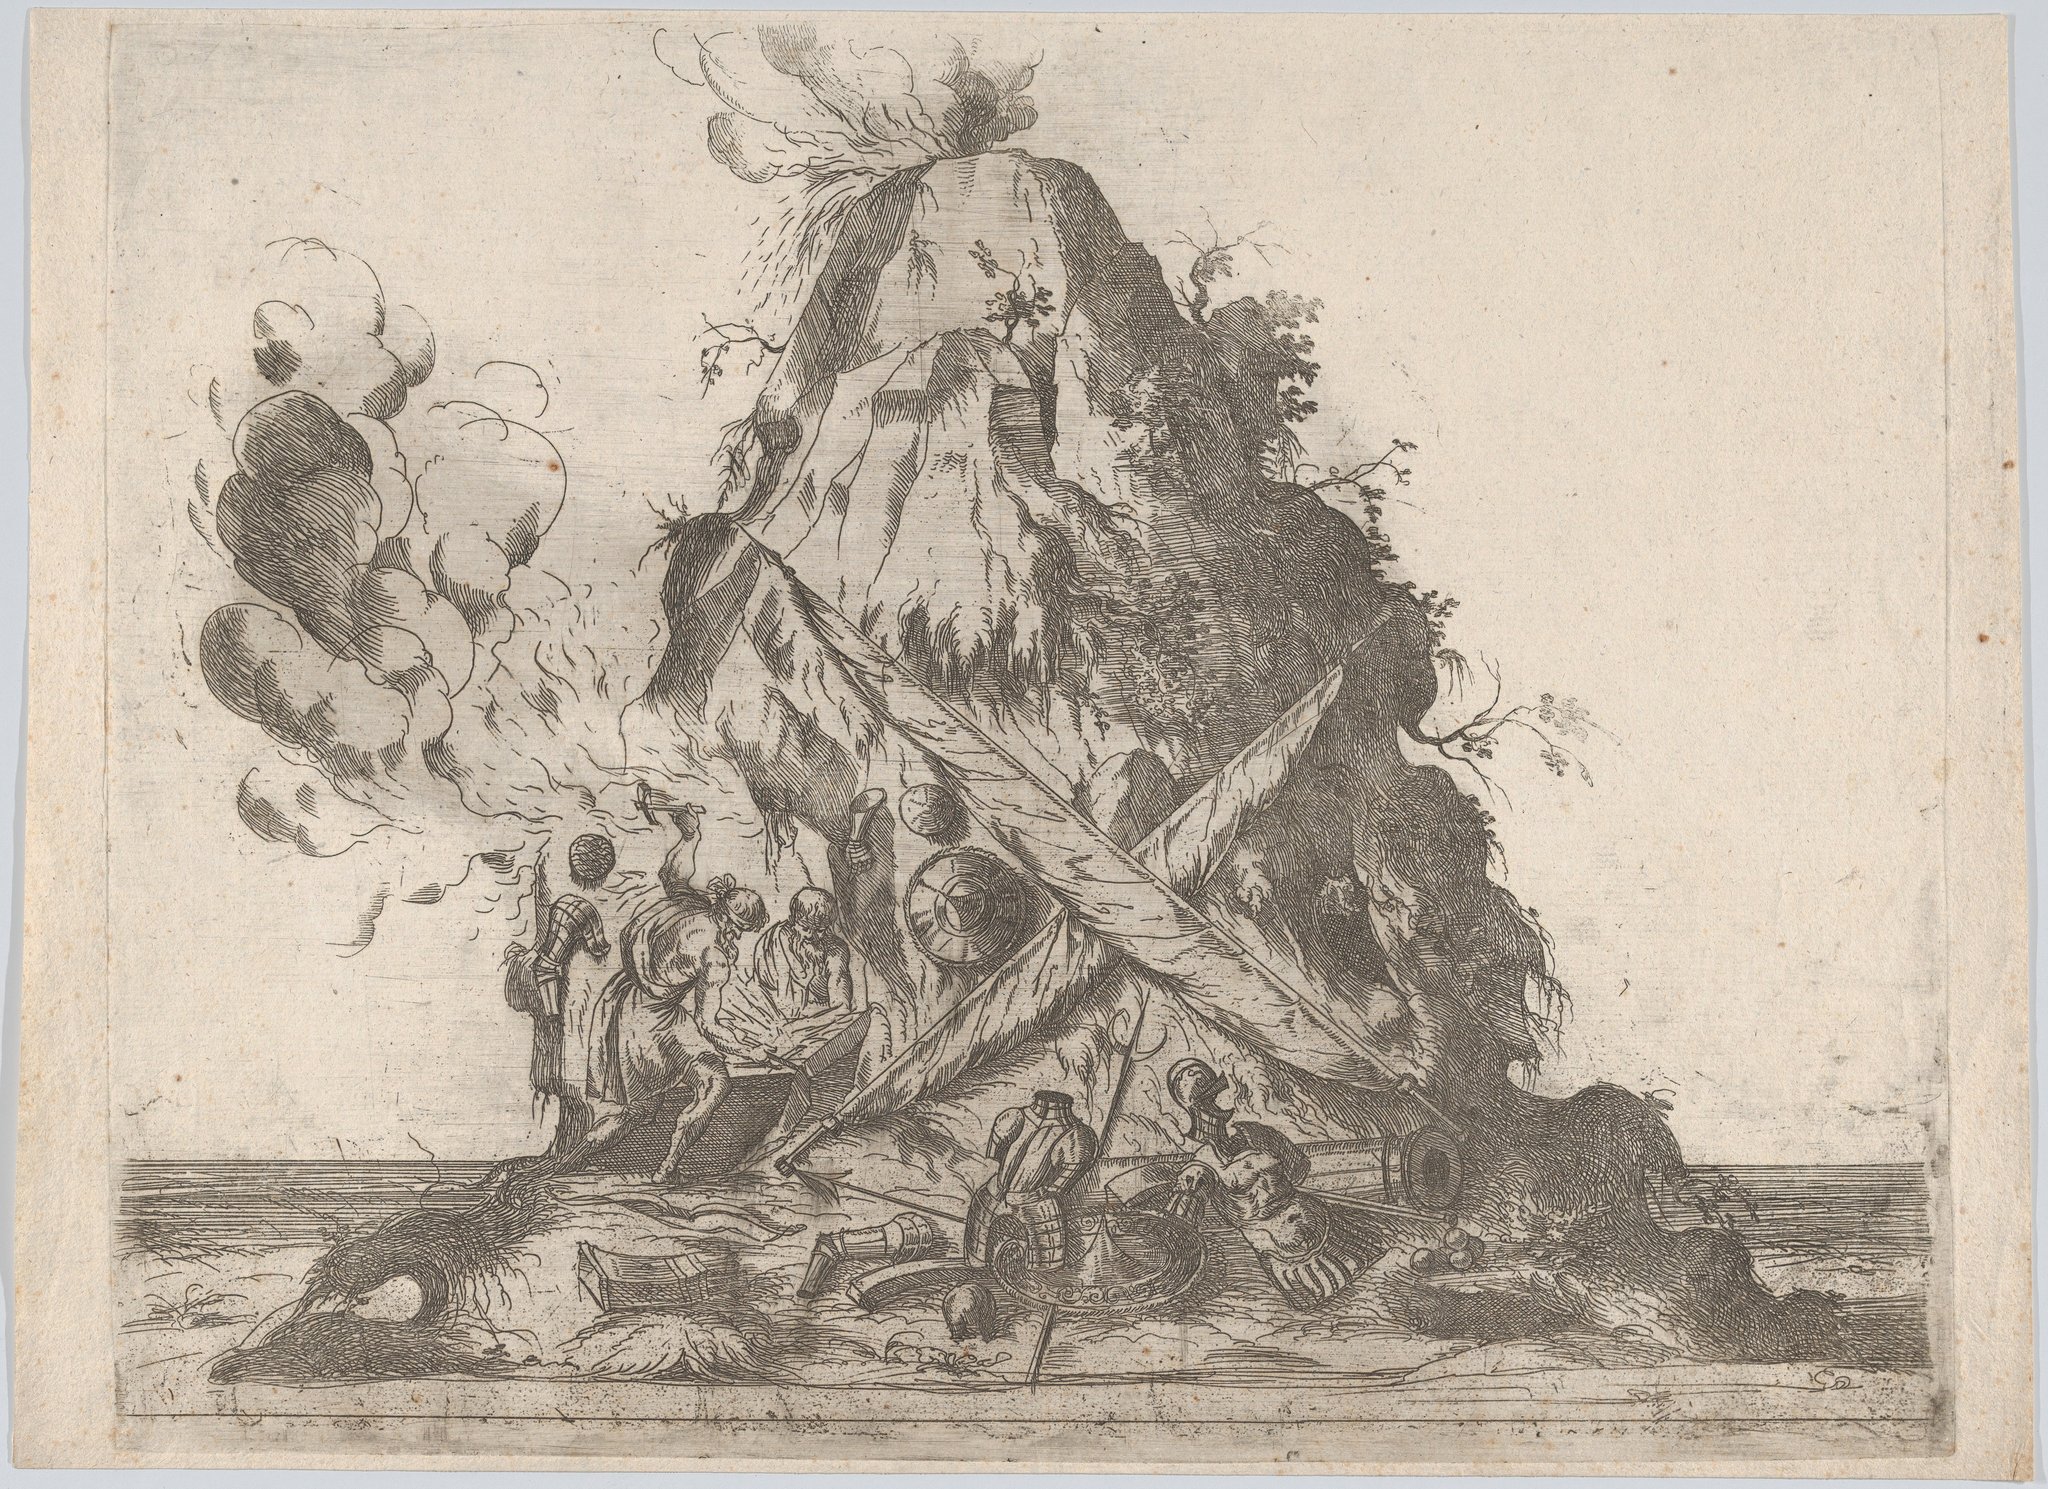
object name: print, fete, ornament architecture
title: Volcano at center with blacksmiths working at left and armor on the ground around them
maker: anonymous, german, 16th century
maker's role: artist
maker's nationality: german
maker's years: 1500-1600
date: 1501-1600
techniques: etching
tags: armor,volcanoes,working,blacksmiths